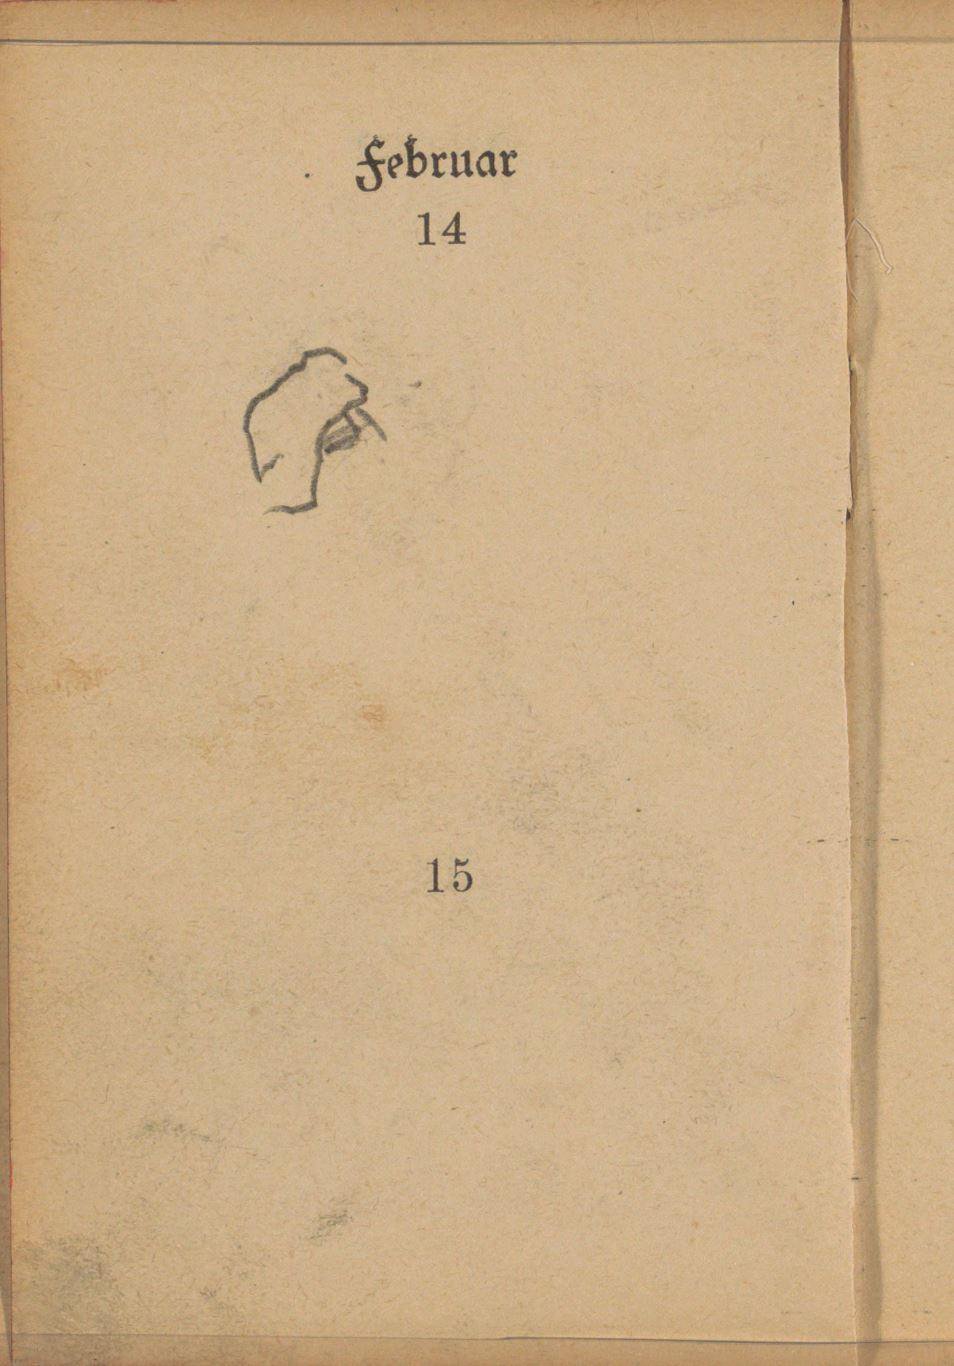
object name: sketchbook leaf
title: Hoofd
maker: george hendrik breitner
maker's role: draughtsman, painter, print maker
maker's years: 1857-1923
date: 1893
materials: paper, pencil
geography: amsterdam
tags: head (human)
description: Pagina 27 uit een als schetsboek gebruikte agenda met 80 bladen.